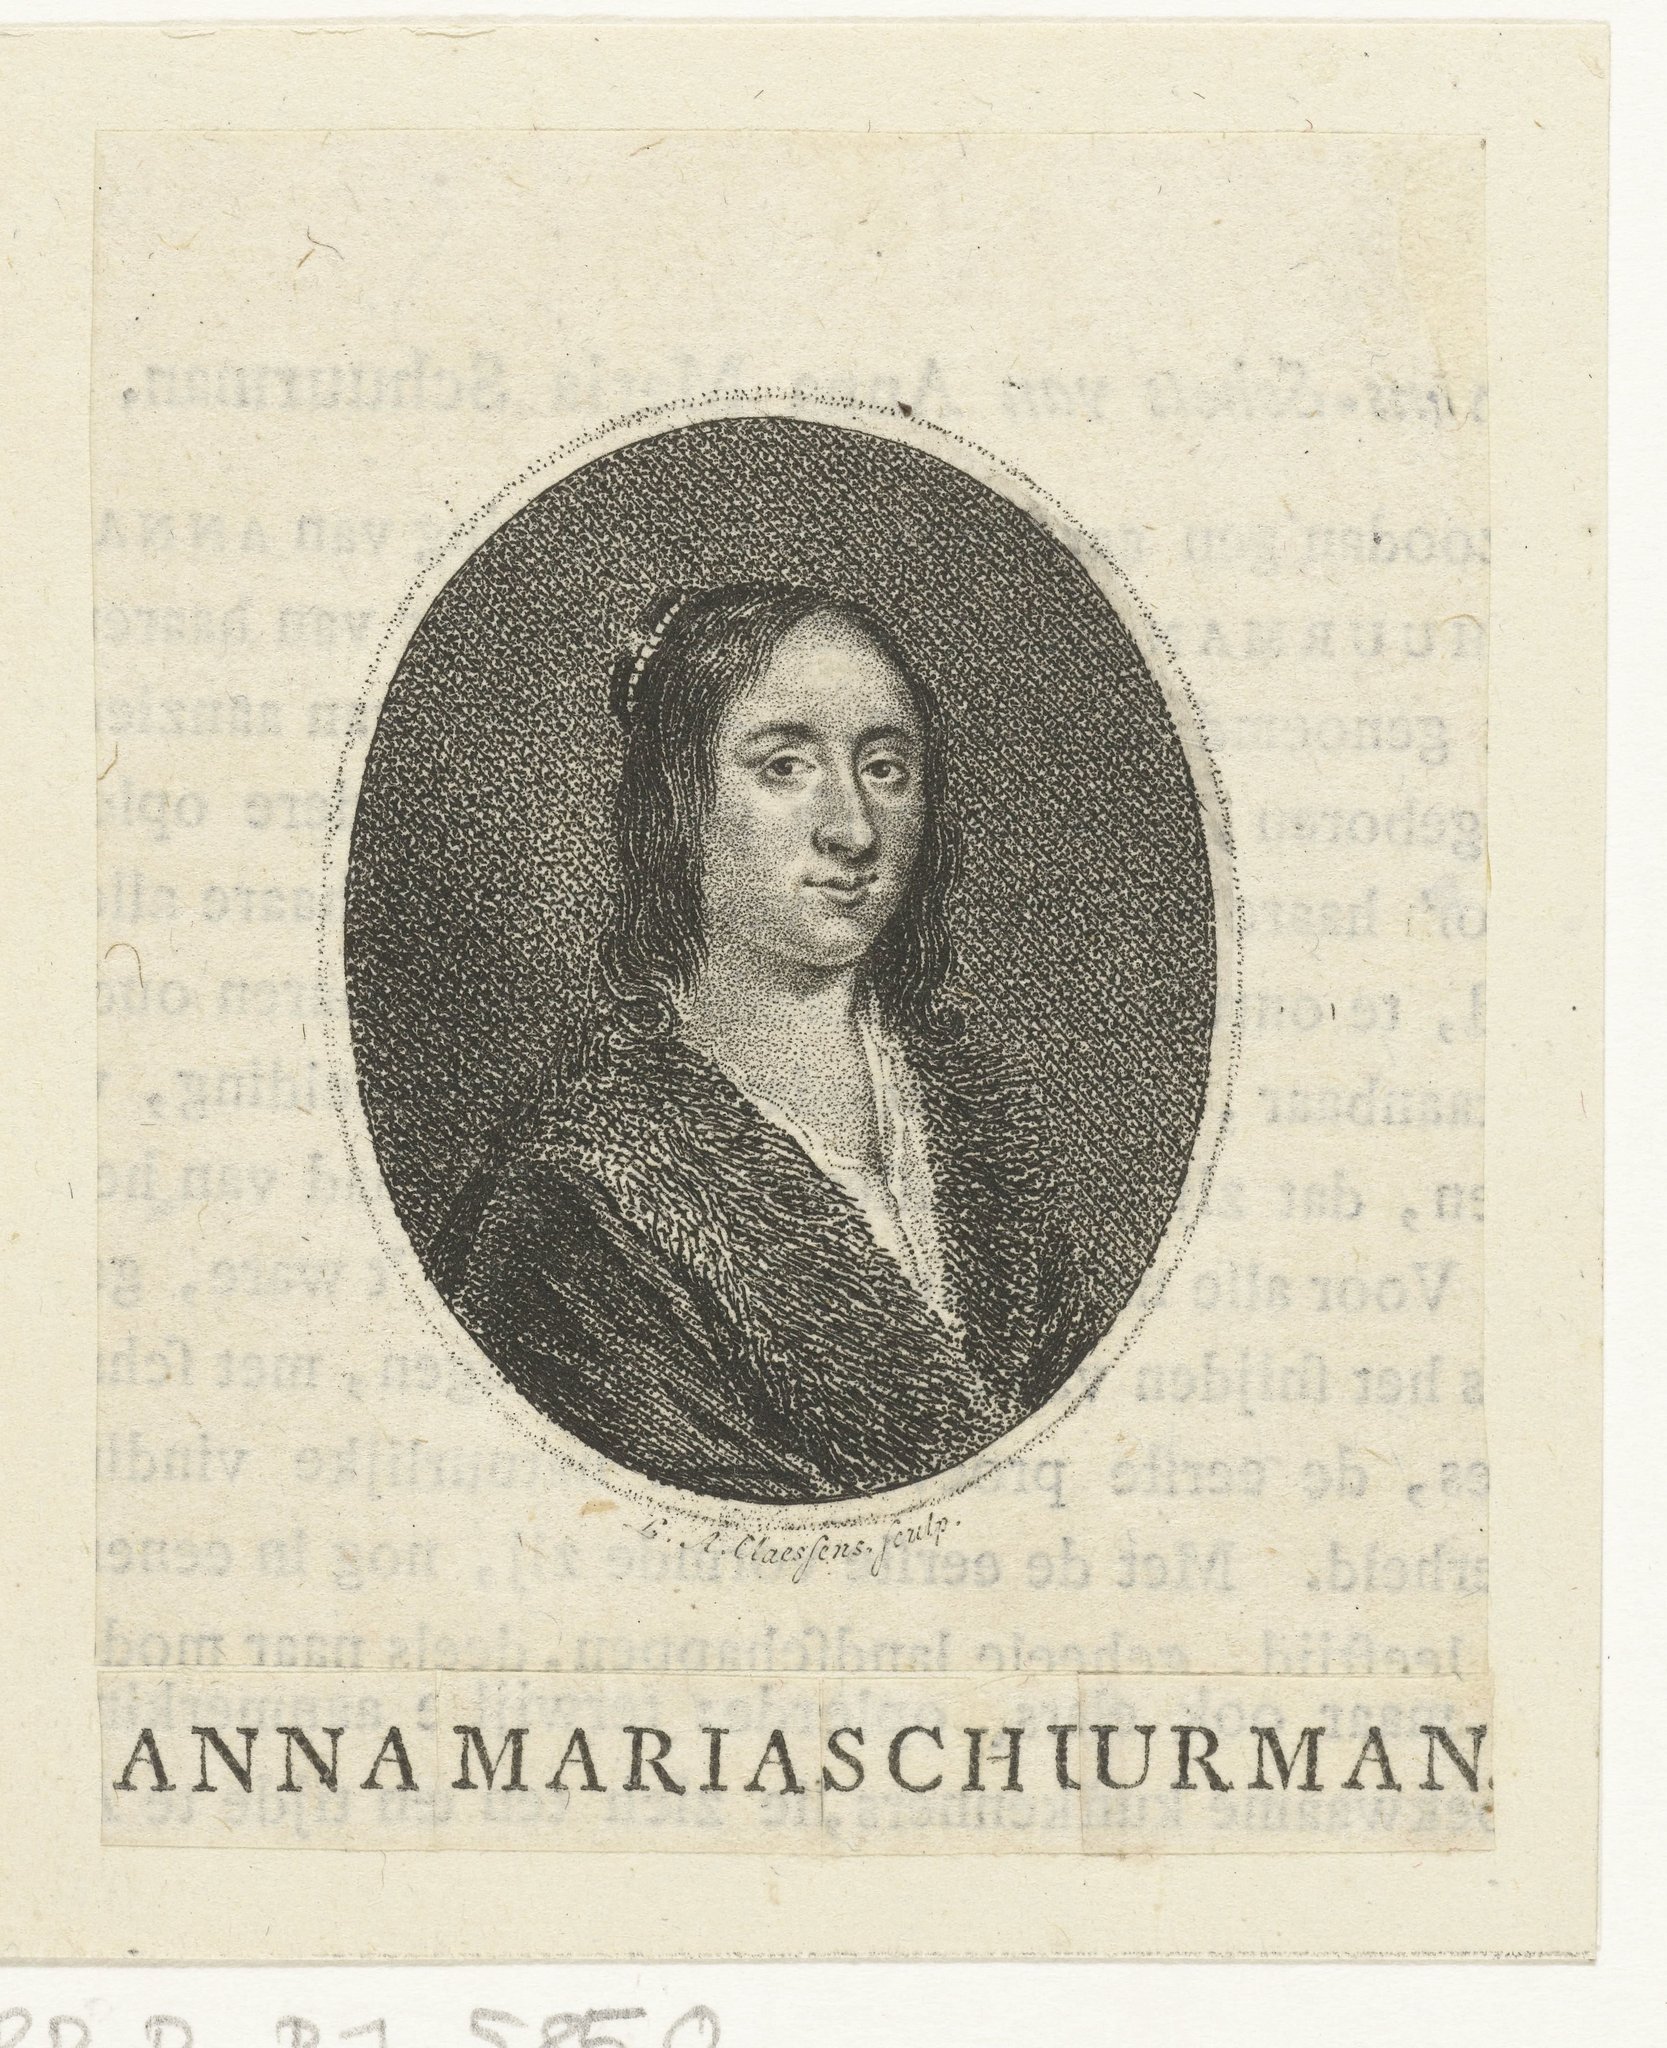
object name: print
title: Portret van Anna Maria van Schurman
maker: lambertus antonius claessens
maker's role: draughtsman, print maker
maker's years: 1763-1834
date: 1792-1808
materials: paper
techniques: etching, letterpress printing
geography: amsterdam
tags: cologne, draughtsman, anna maria van schurman